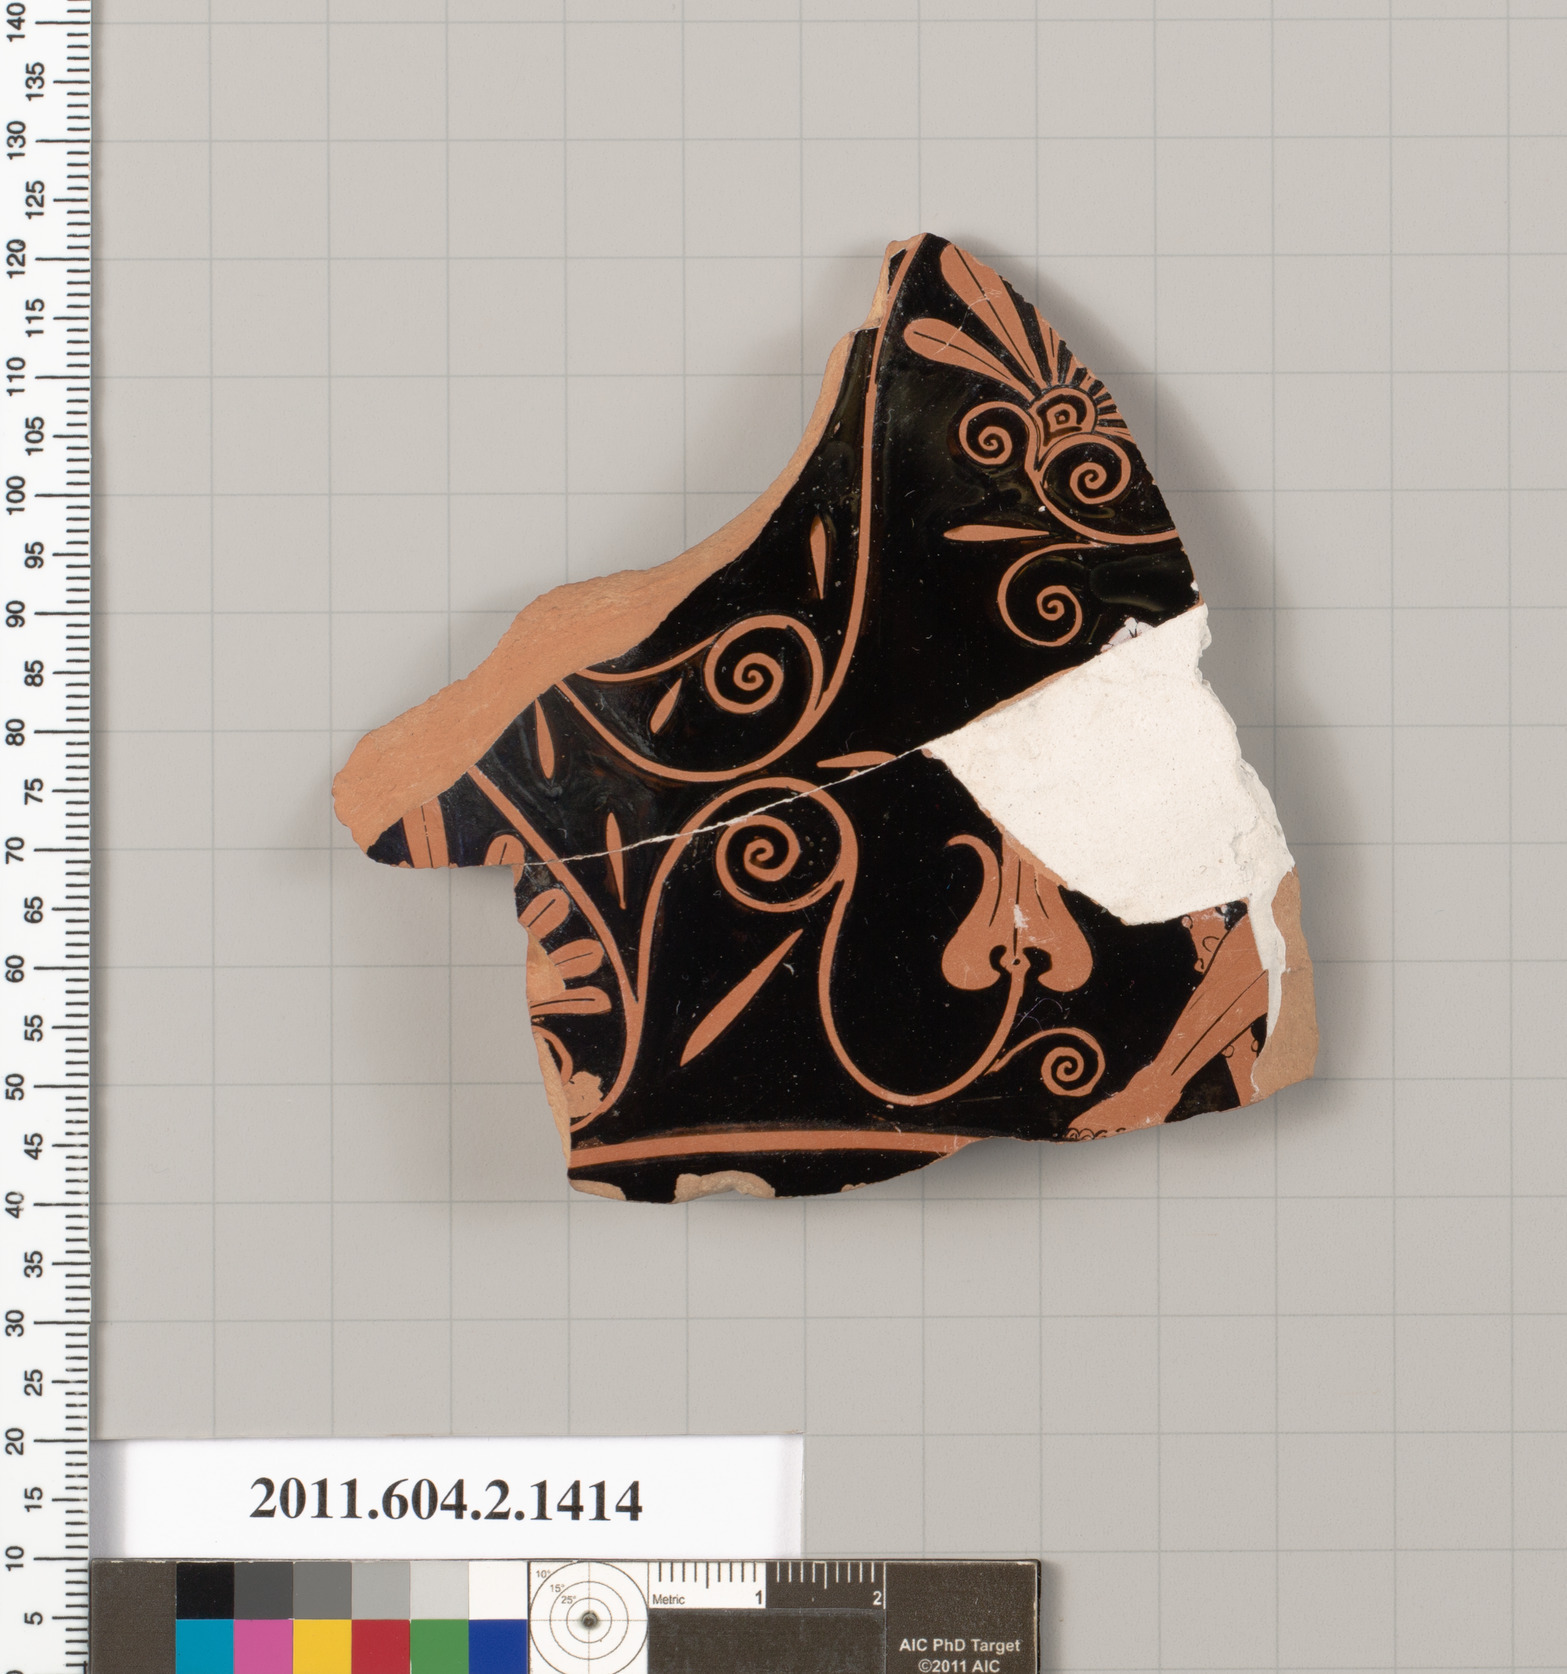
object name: skyphos fragment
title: Terracotta fragment of a skyphos (deep drinking cup)?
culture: greek, attic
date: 490-470 BCE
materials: terracotta